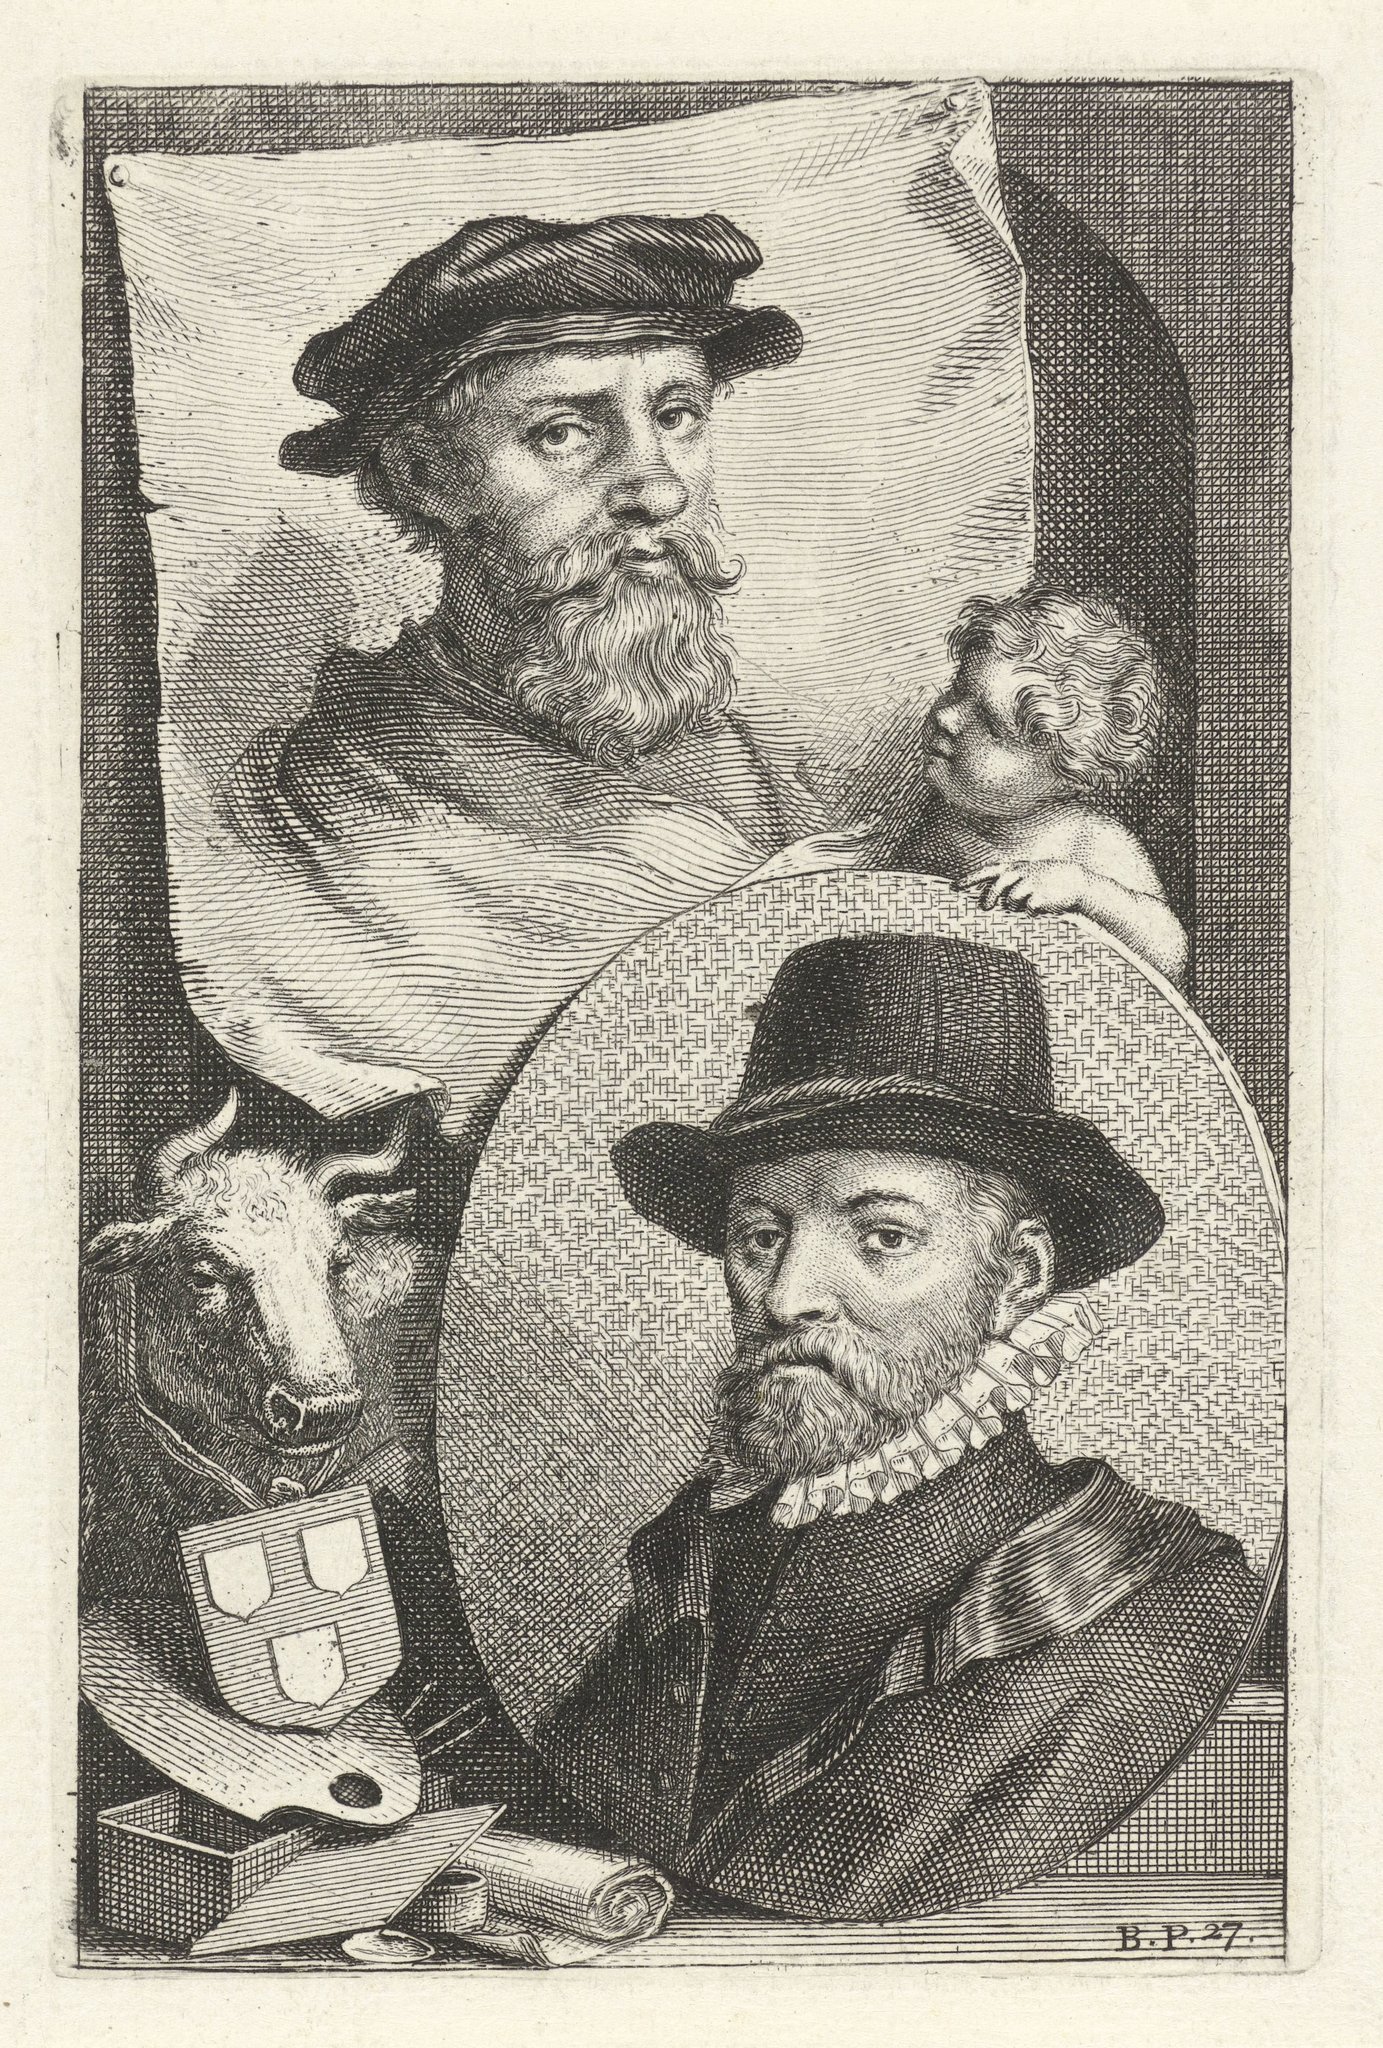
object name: print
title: Portretten van Dirck en Wouter Pietersz. Crabeth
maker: jacob houbraken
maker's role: draughtsman, print maker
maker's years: 1698-1780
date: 1753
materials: paper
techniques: engraving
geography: amsterdam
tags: gouda, draughtsman, dirck pietersz. crabeth, designer, wouter pietersz i crabeth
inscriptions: collector's mark: Lugt 2228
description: Prent ook gebruikt in: Arnold Houbraken. De groote Schouburgh der Nederlantsche konstschilders en schilderessen : waar van 'er vele met hunne beeltenissen ten tooneel verschynen, ... zynde een vervolg op het Schilderboek van K. van Mander. 3 dln. Tweede druk. Den Haag: 1753.